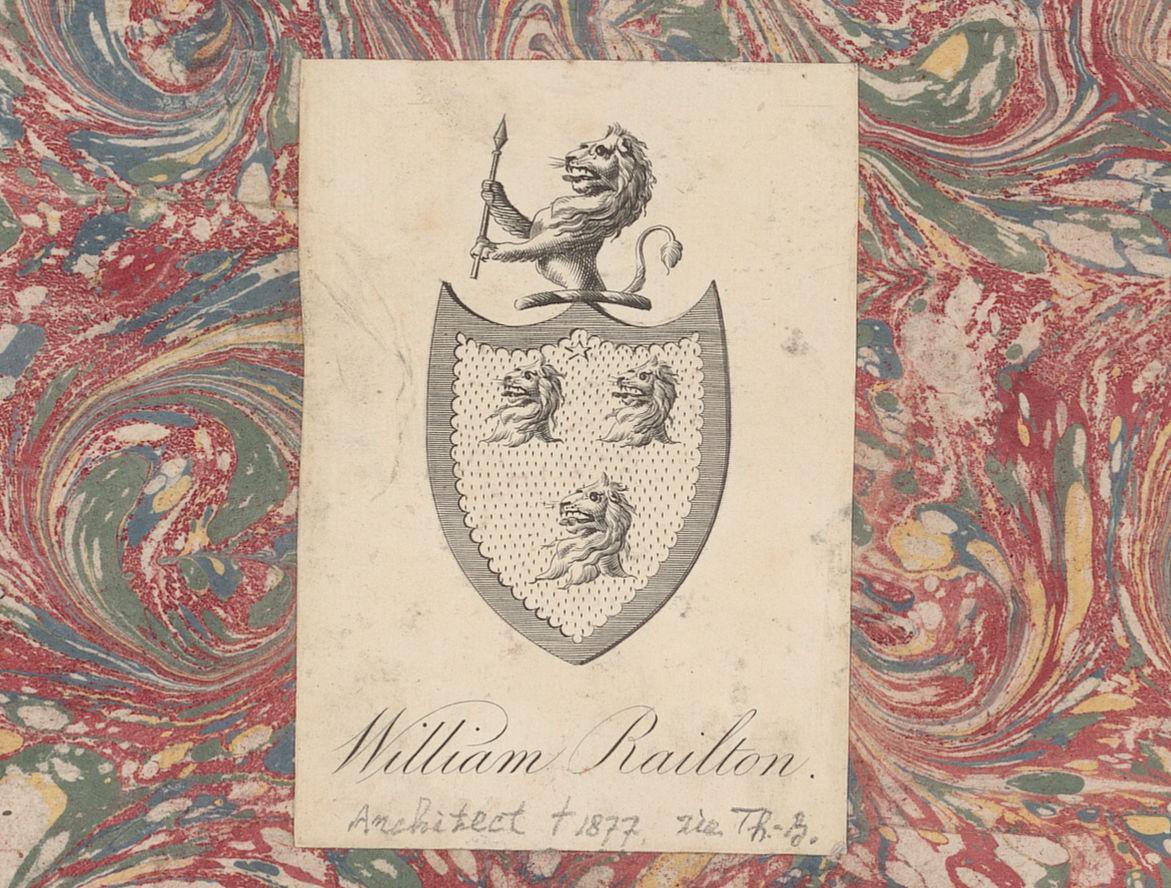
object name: print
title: Schutblad met ex libris van William Railton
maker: Anonymous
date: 1800-1877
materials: paper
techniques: engraving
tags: armorial bearing, heraldry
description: Leeuw met een pijl boven een wapenschild met drie leeuwenkoppen.